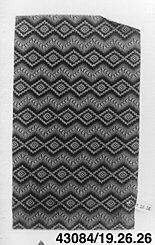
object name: sample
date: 1840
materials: cotton